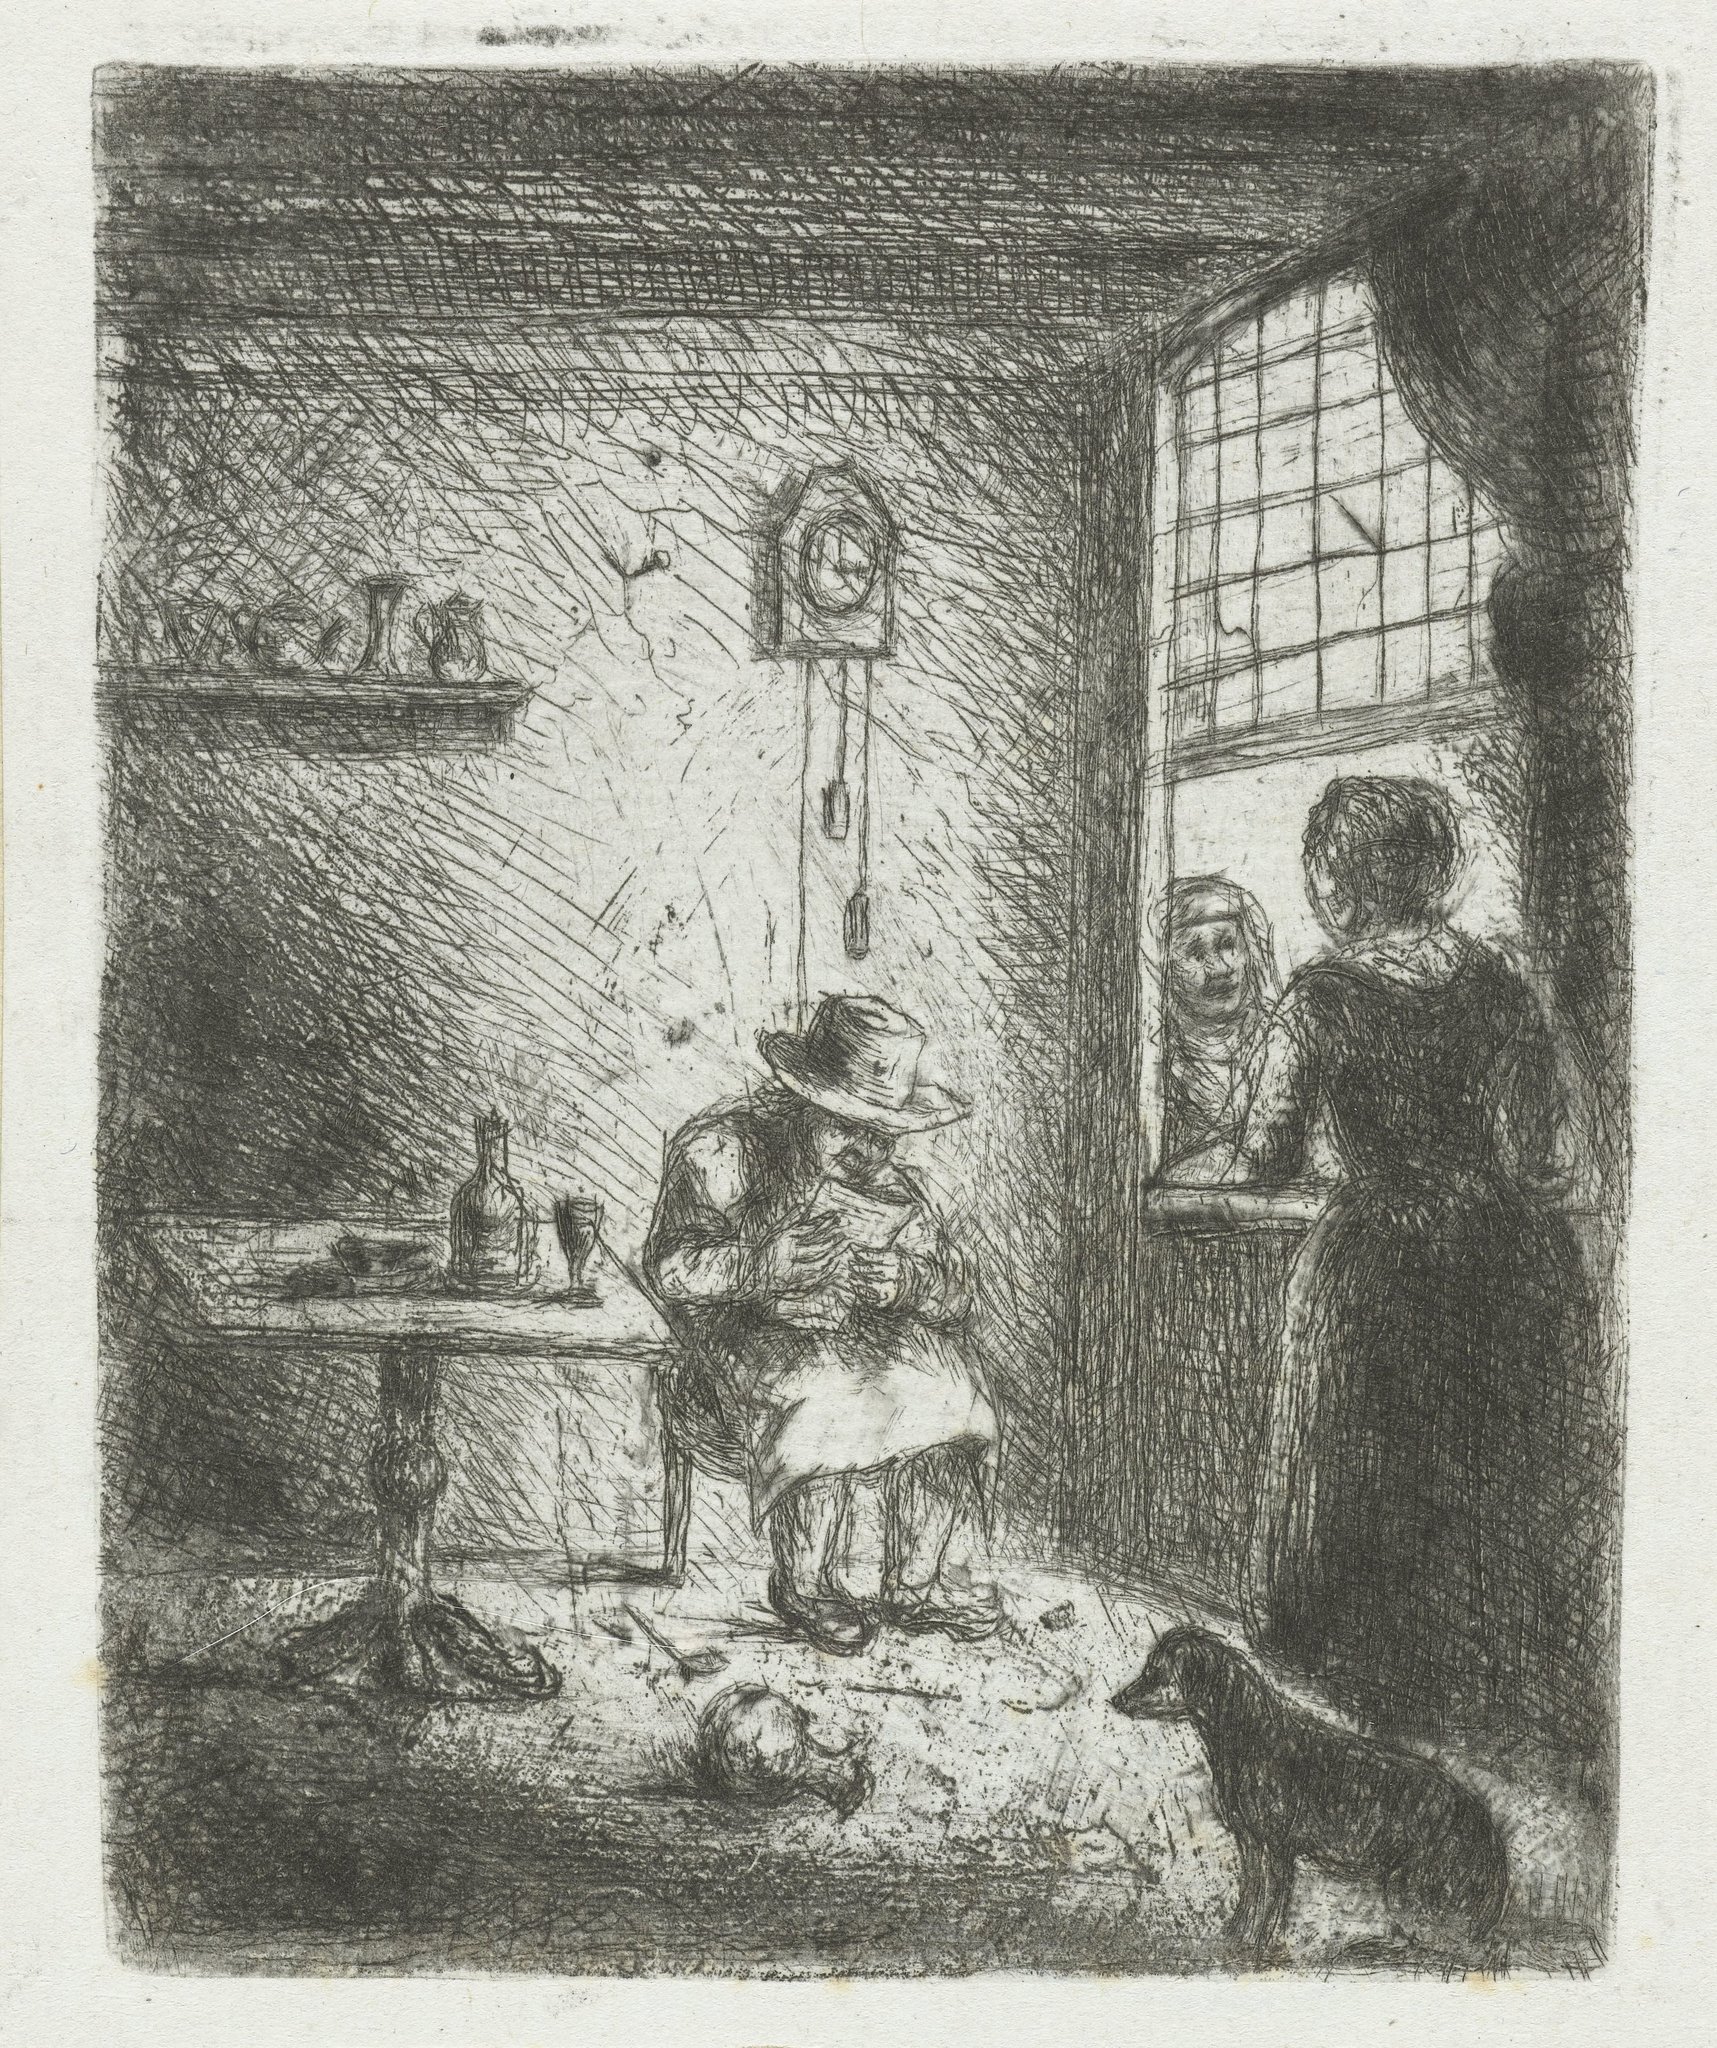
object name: print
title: Interieur van een huis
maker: jan chalon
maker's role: print maker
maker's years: 1738-1795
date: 1748-1795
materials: paper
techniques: drypoint, etching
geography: northern netherlands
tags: reading, dogs (circus performance), pamphlet ~ printed matter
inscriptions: collector's mark: Lugt 924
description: Interieur van een huis. Een man zit een pamflet te lezen op een stoel. Twee vrouwen praten met elkaar door een open raam. Een hond op de voorgrond.